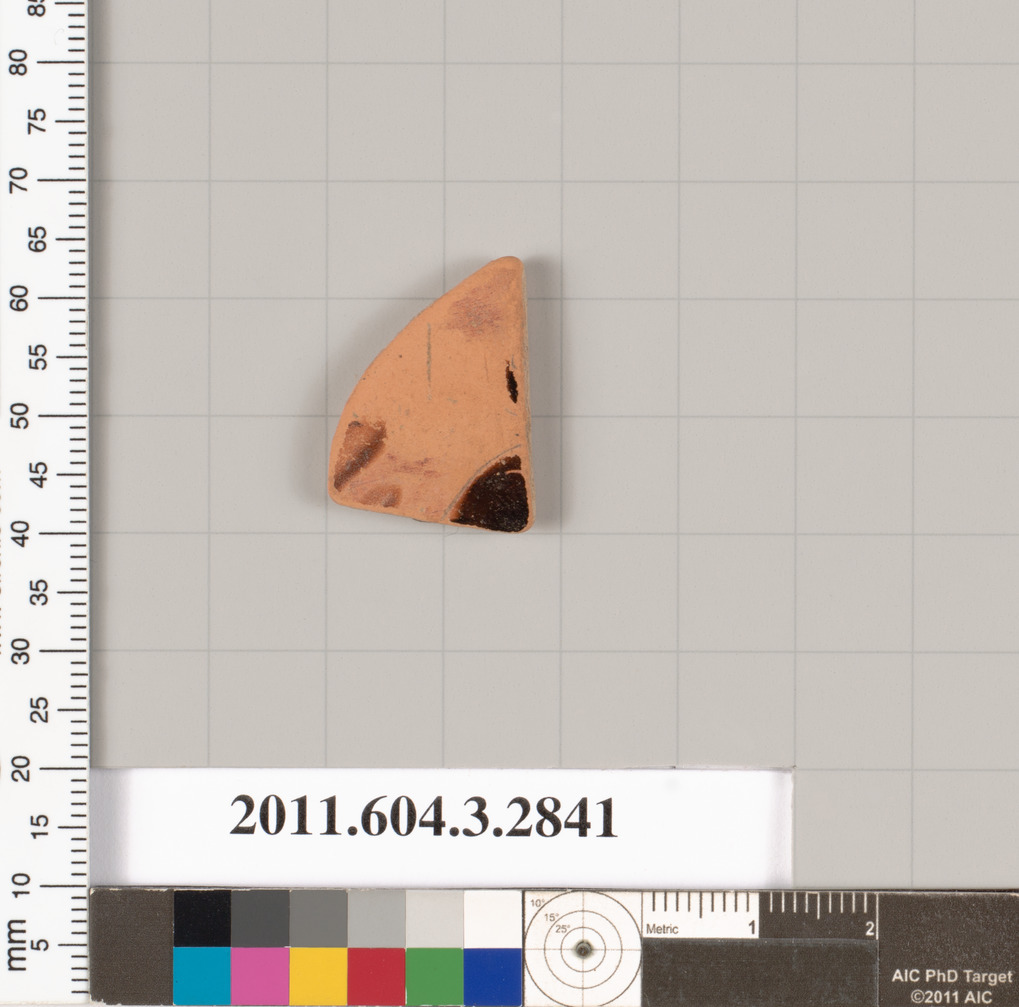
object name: undetermined closed shape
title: Terracotta fragment of a closed shape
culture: greek, attic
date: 534-468 BCE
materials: terracotta